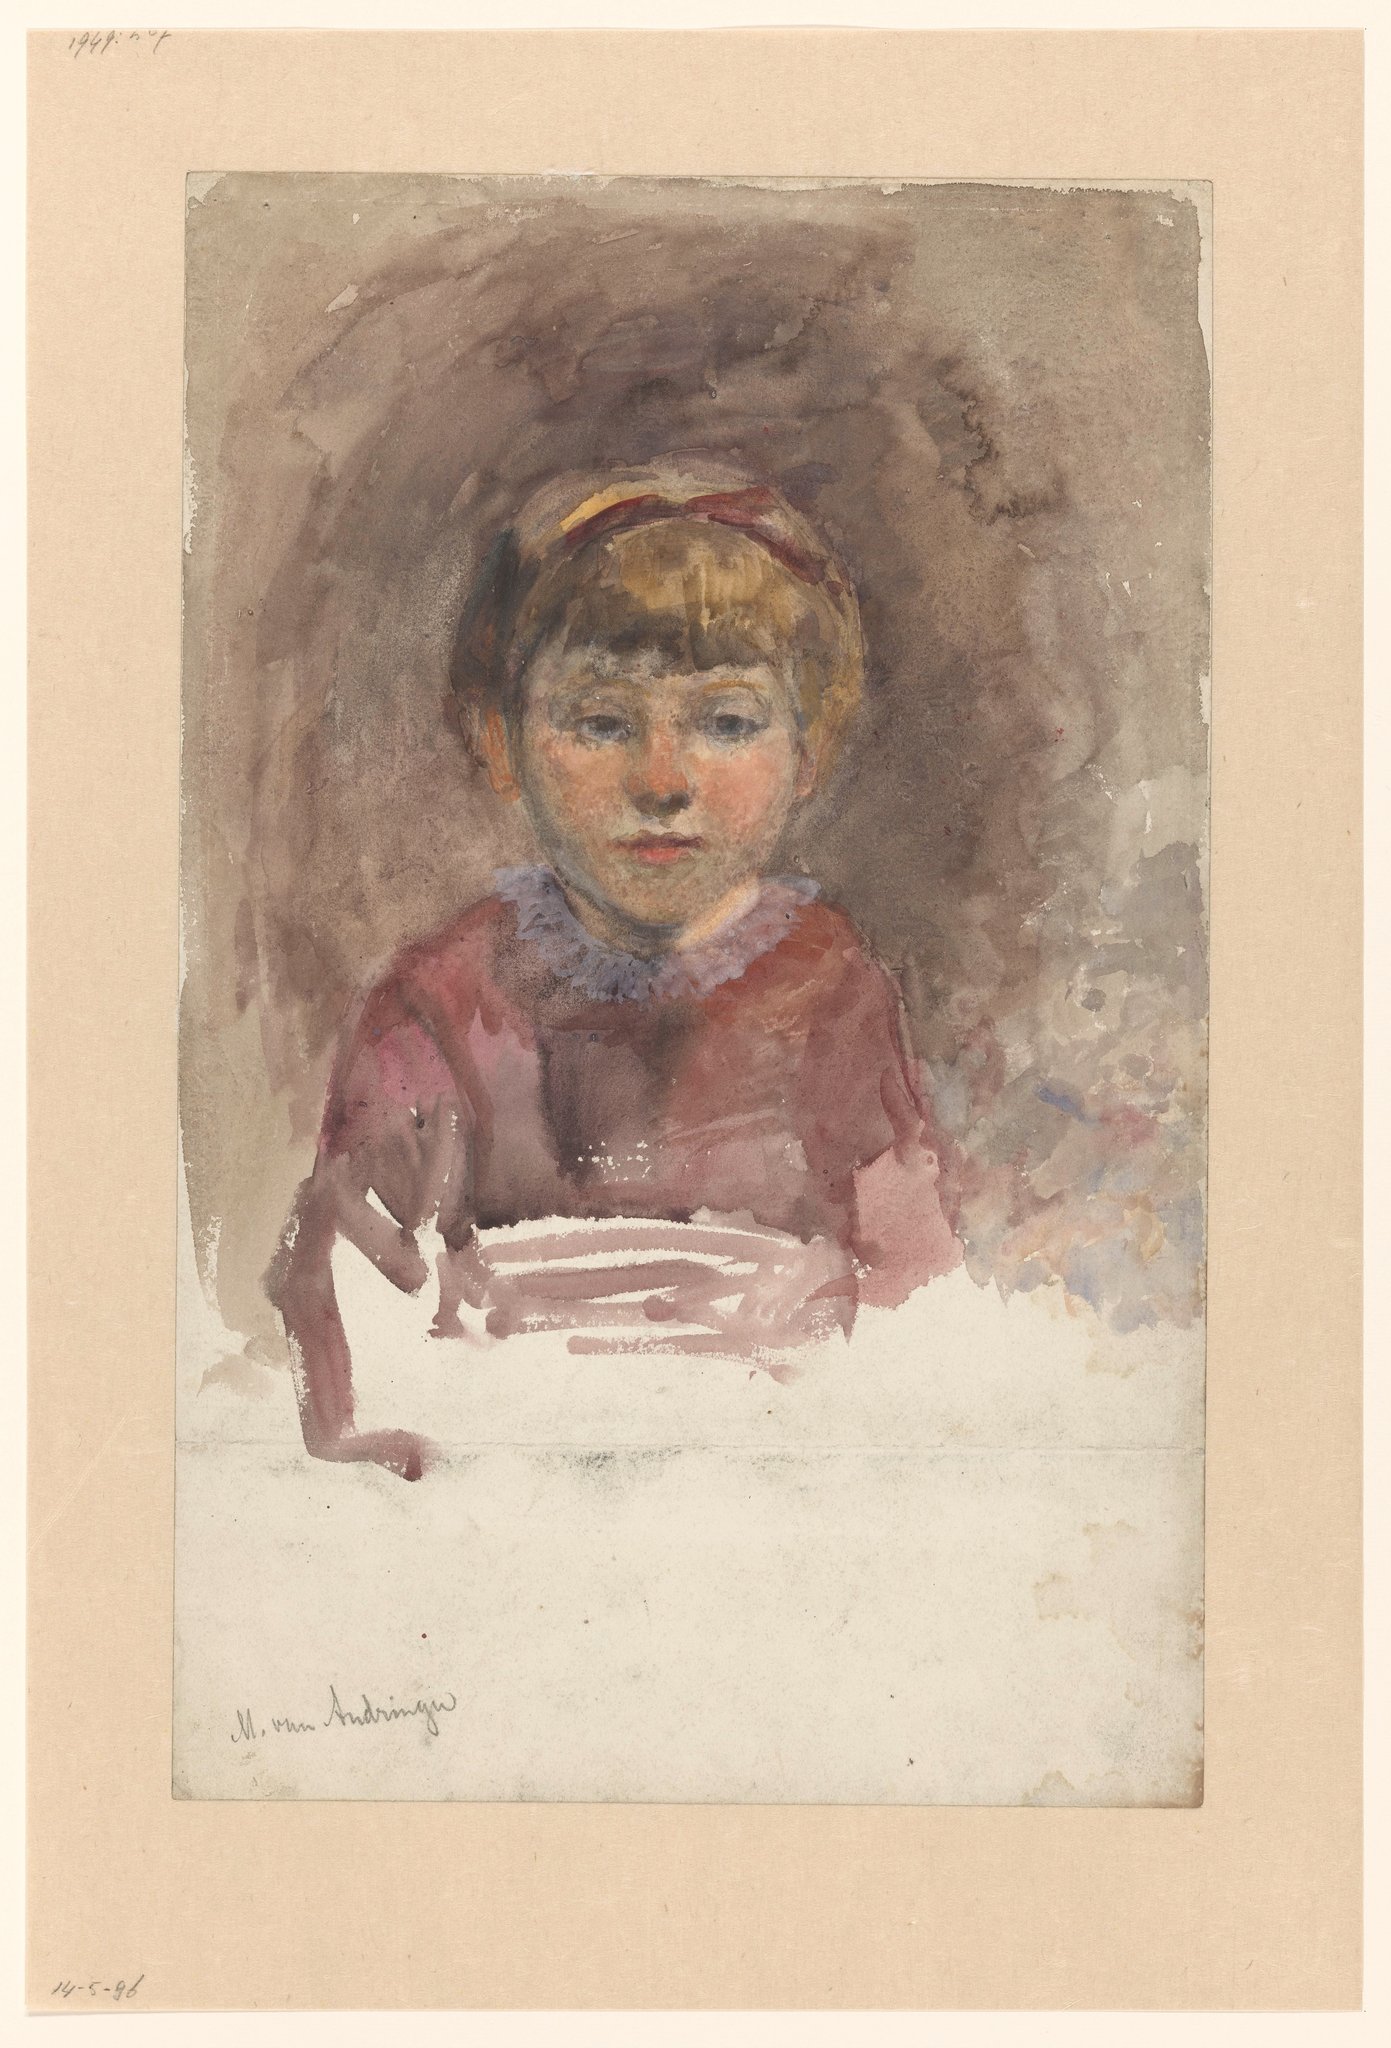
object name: watercolor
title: Kinderportretje, en face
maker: martinus van andringa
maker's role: draughtsman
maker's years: 1864-1918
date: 1874-1918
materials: paper, pencil, watercolor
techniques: brush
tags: anonymous historical person portrayed alone